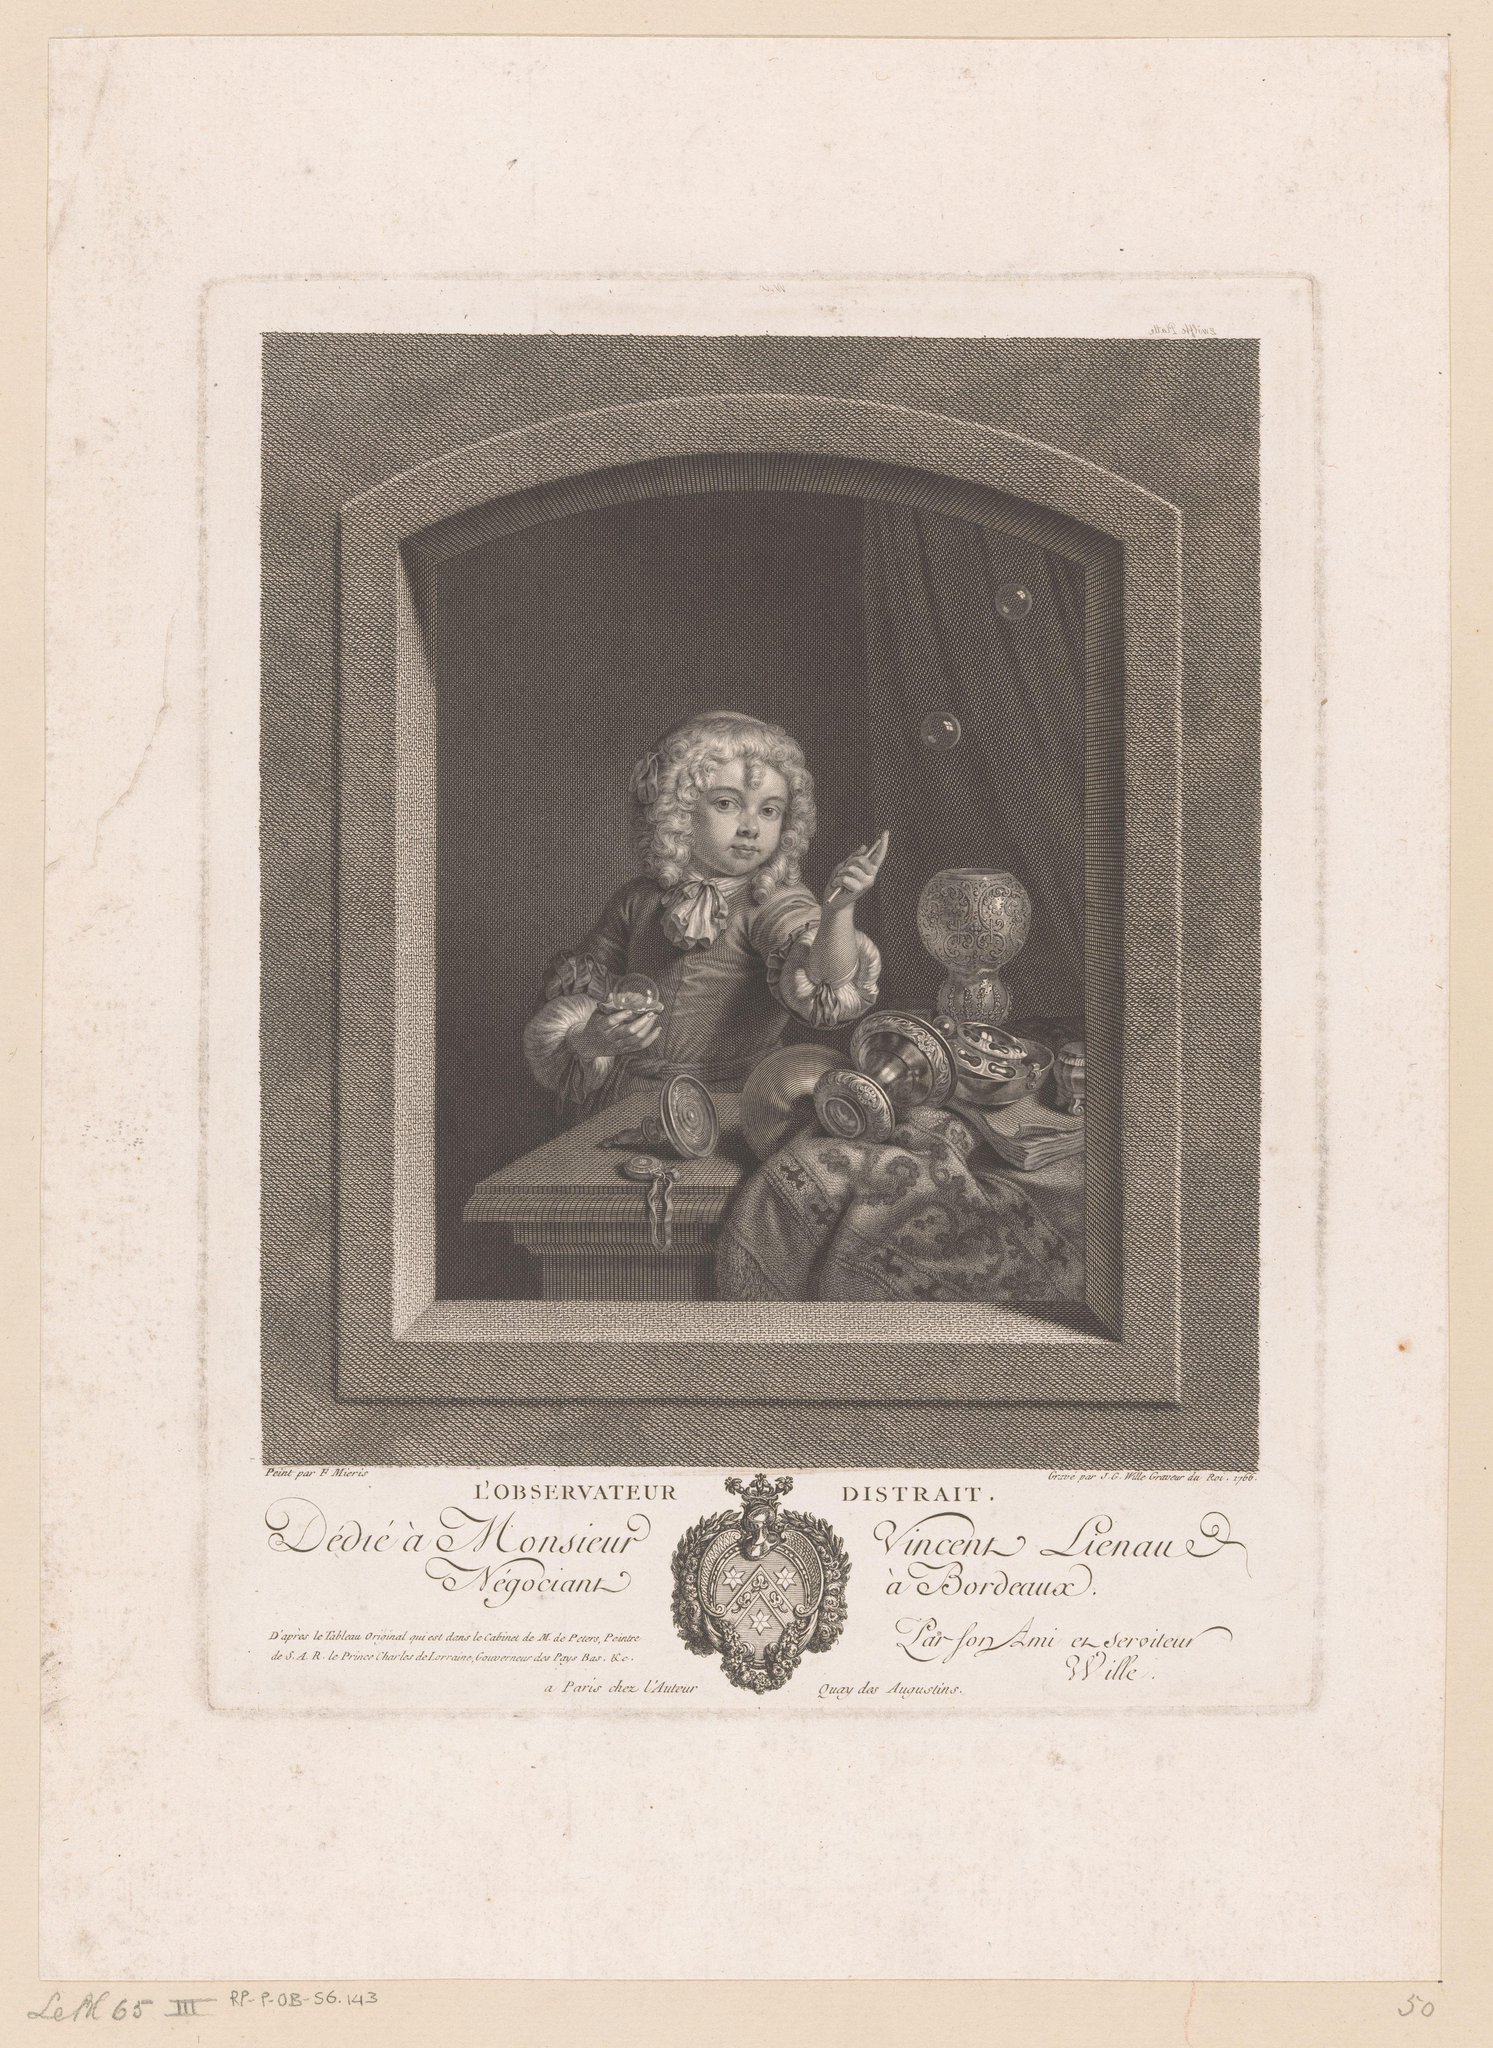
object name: print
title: Jongen die zeepbellen blaast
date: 1766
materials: paper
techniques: engraving, etching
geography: paris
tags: bubble-blowing (children's games and plays), boy (child between toddler and youth)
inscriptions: collector's mark: Lugt 240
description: Deze prent maakt deel uit van een serie van onbekende omvang naar Nederlandse en Duitse schilderijen. Op sommige prenten staat linksboven aangegeven welk nummer in de serie het betreft.